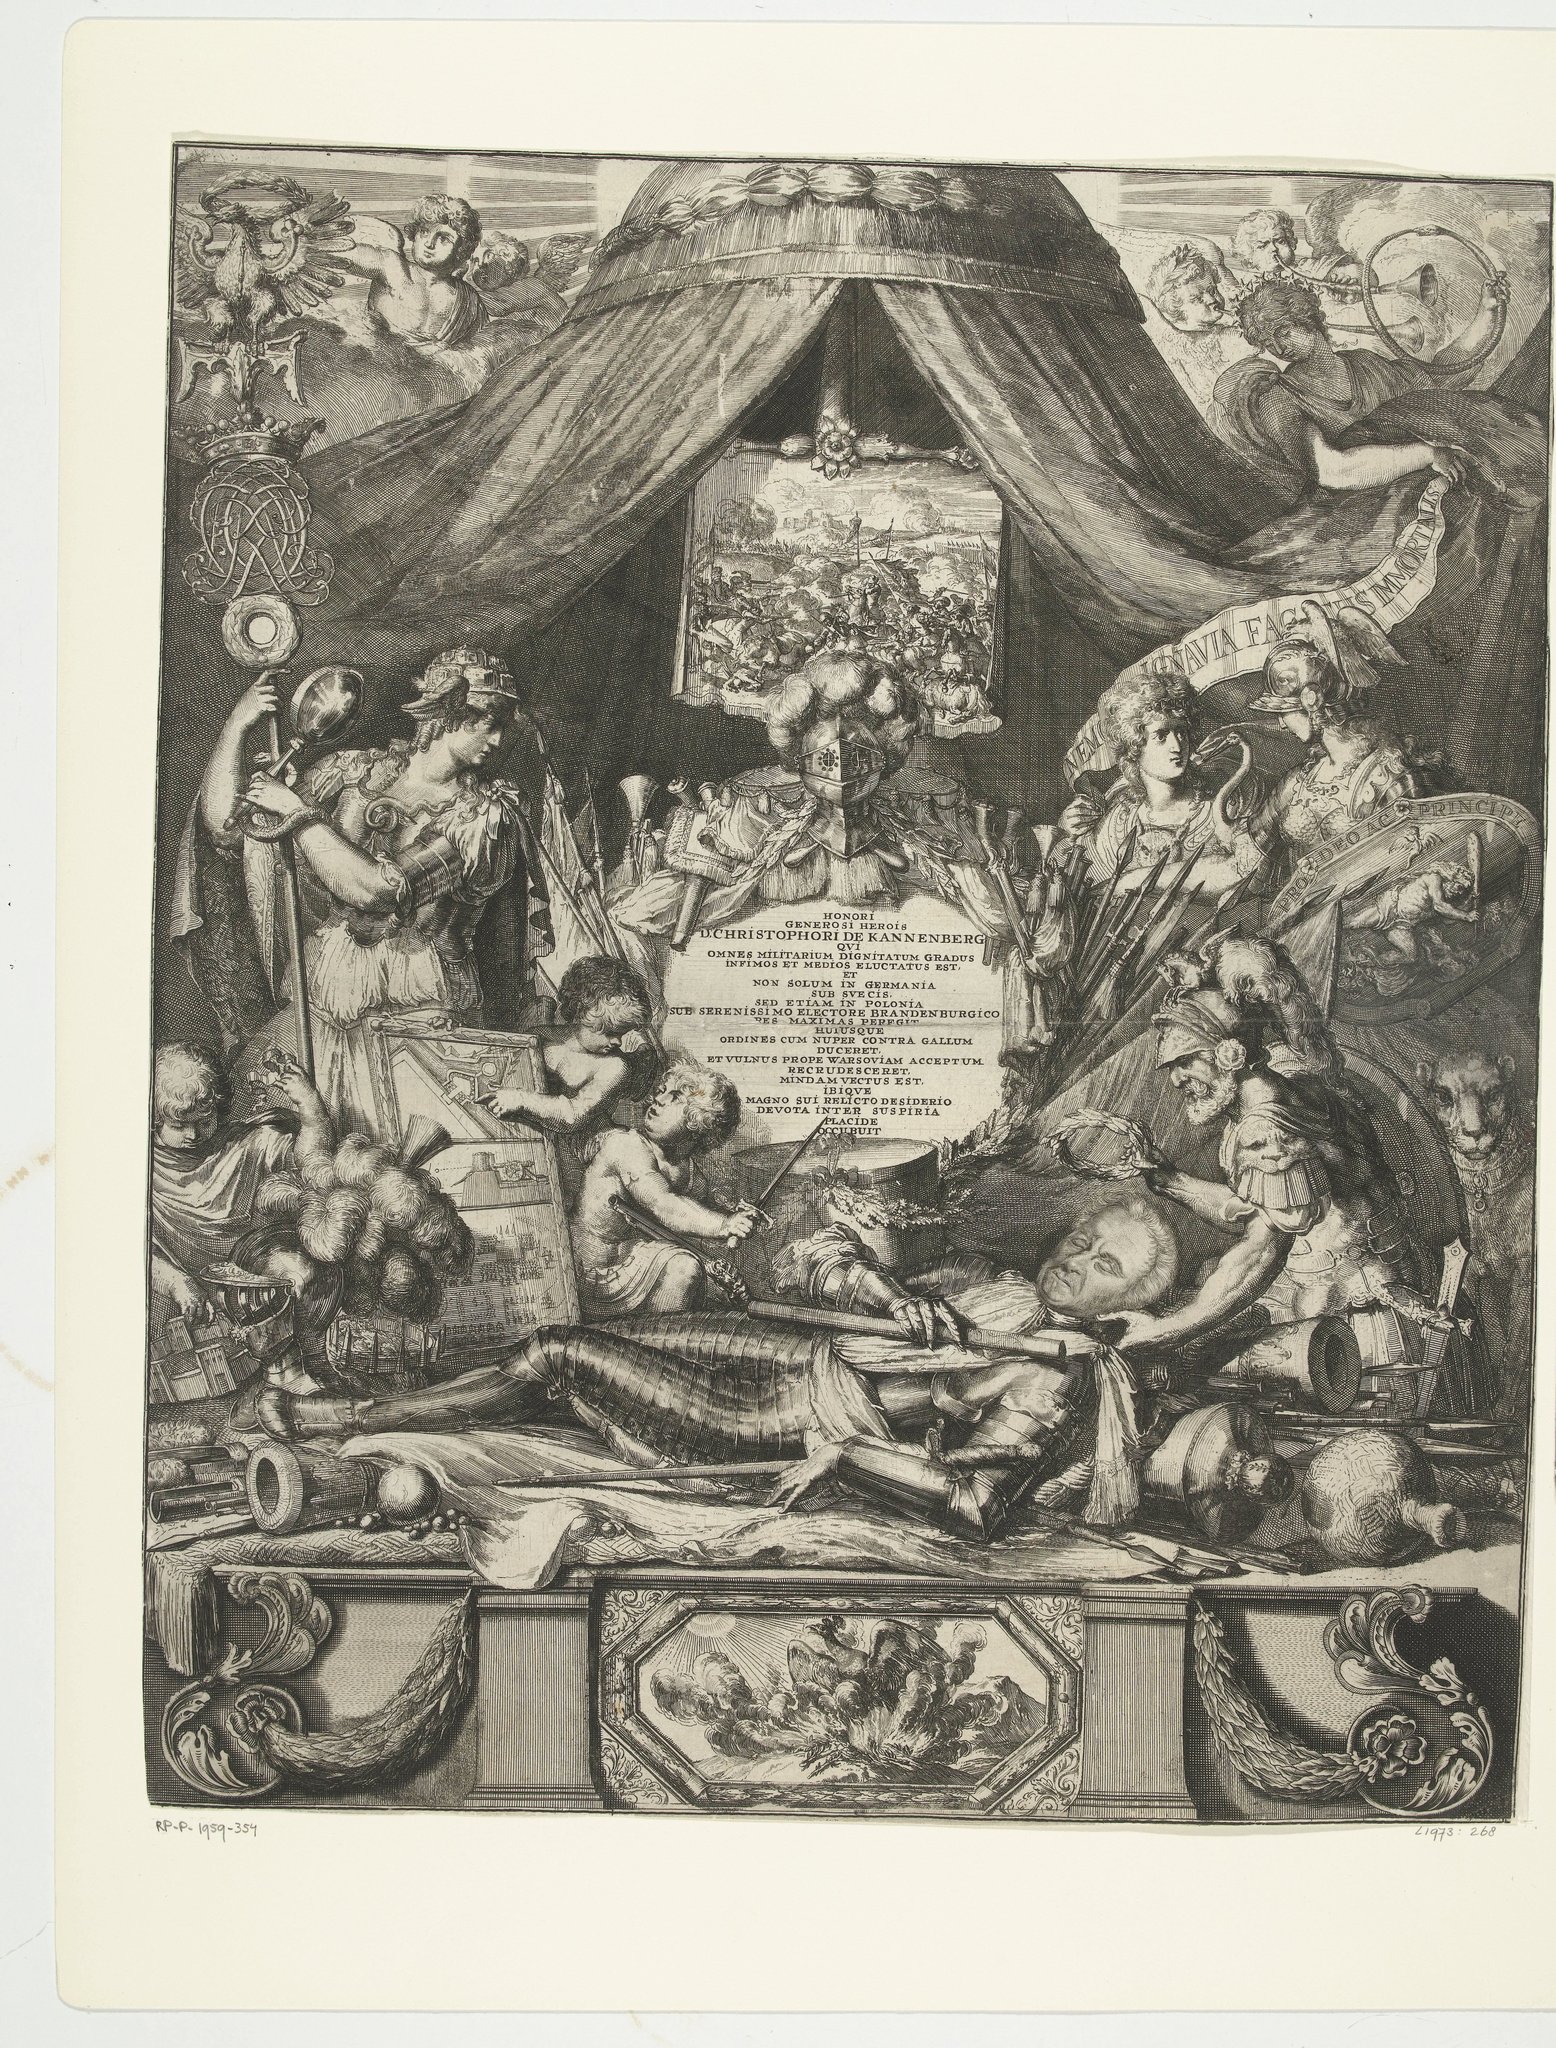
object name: print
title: Allegorie op de dood van Christoph von Kannenberg, 1673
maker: romeyn de hooghe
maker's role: draughtsman, goldsmith, painter, print maker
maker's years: 1645-1708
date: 1673-1674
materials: paper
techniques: engraving, etching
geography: netherlands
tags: burial rites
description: Allegorie op de dood van Christoph von Kannenberg op 10 februari 1673. Mausoleum met het lichaam van de overleden generaal. Met symbolische figuren en motieven die naar zijn wapenfeiten verwijzen. Middenin een opschrift in het Latijn. Onderin een voorstelling van een feniks.